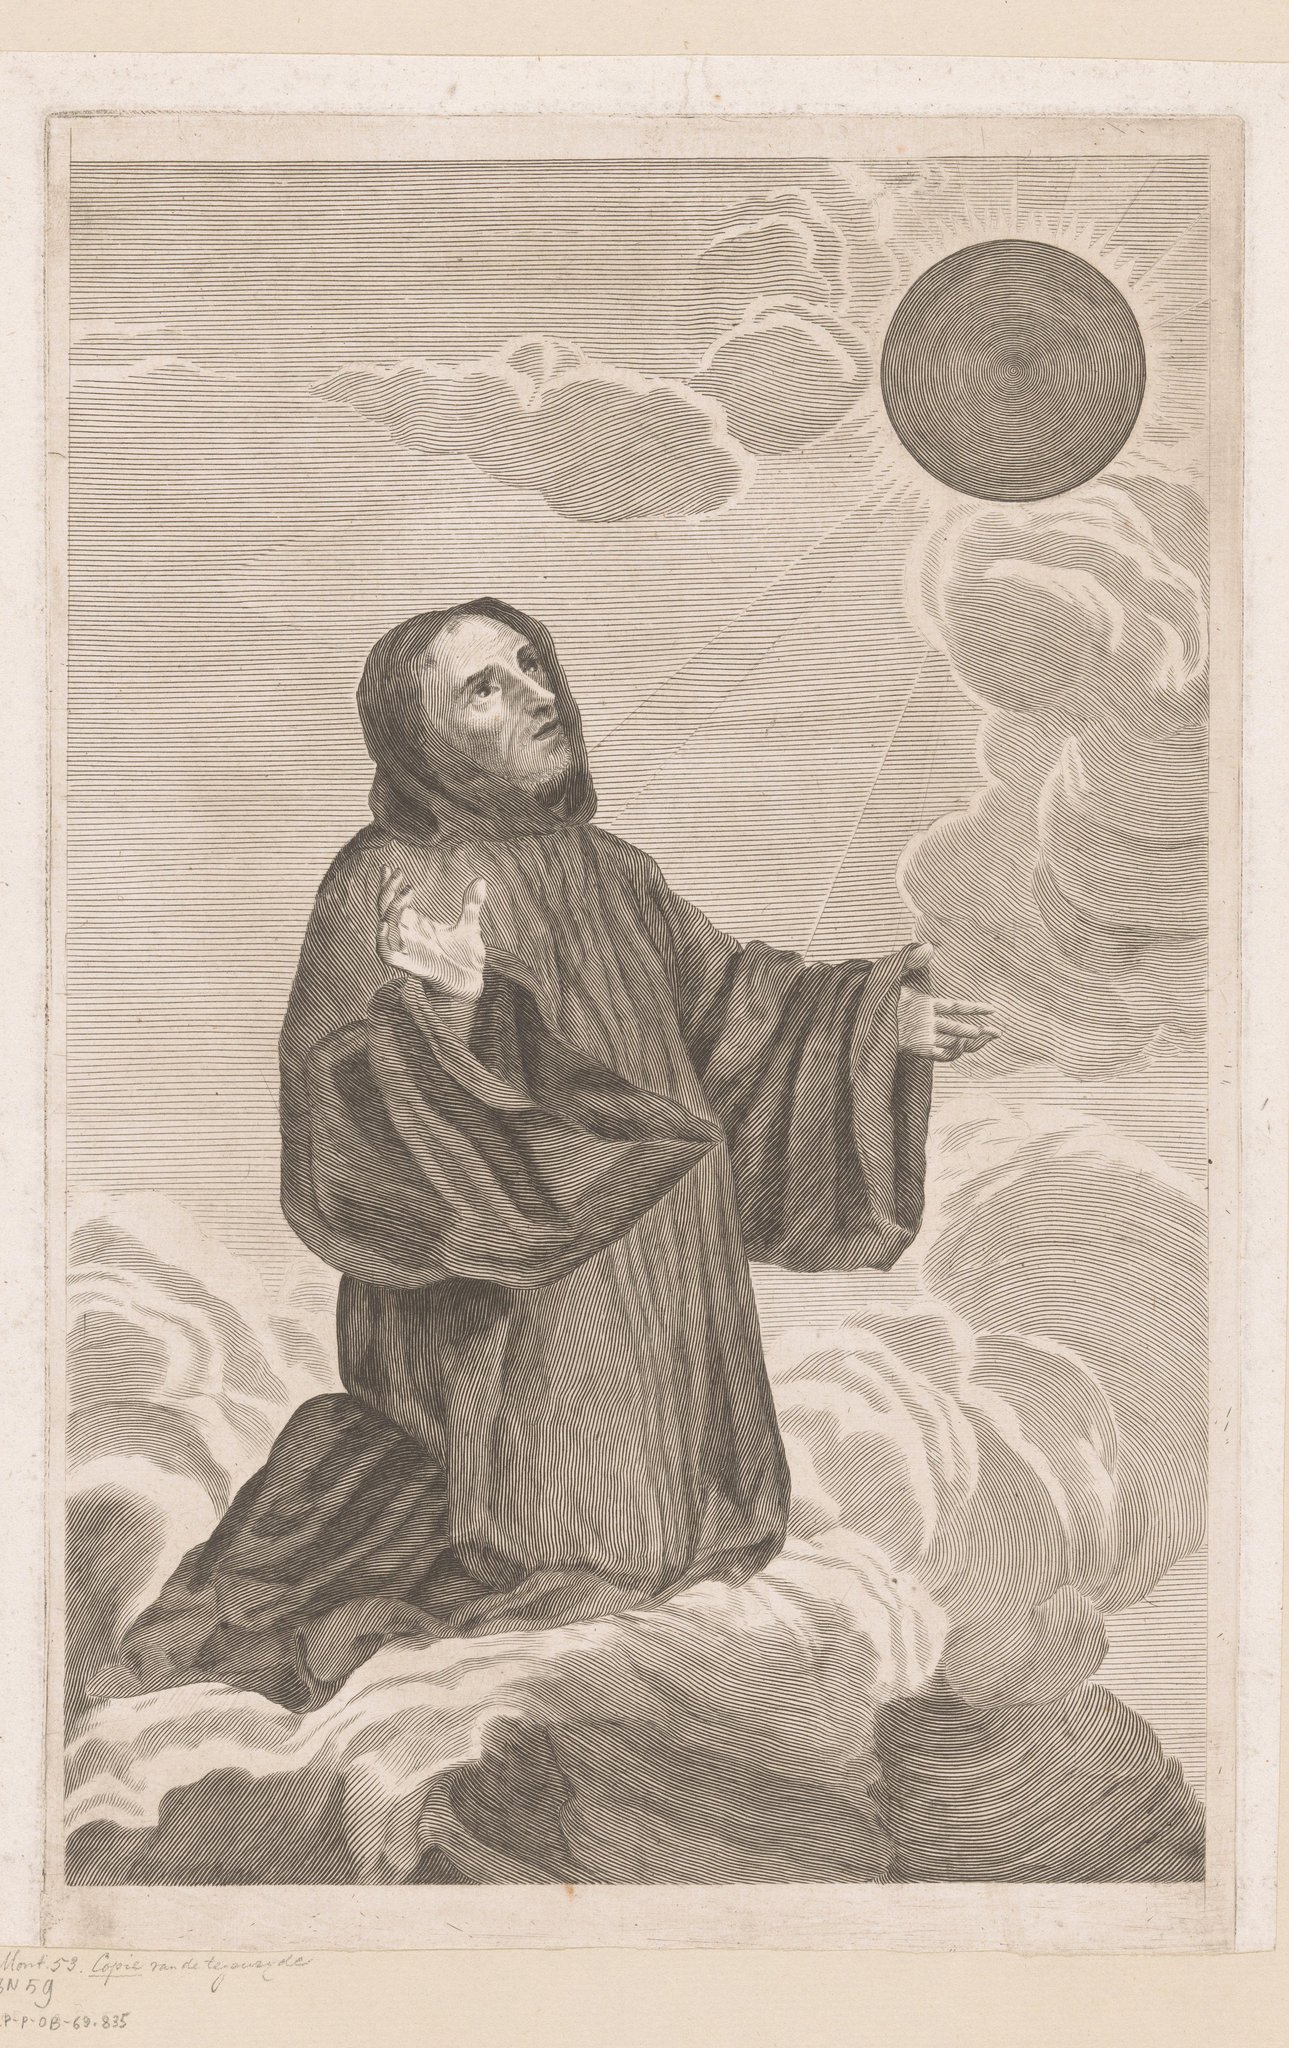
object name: print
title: H. Benoît in extase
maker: Anonymous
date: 1608-1688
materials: paper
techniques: engraving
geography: france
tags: total solar eclipse with corona, monk(s), friar(s)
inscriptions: collector's mark: Lugt 240